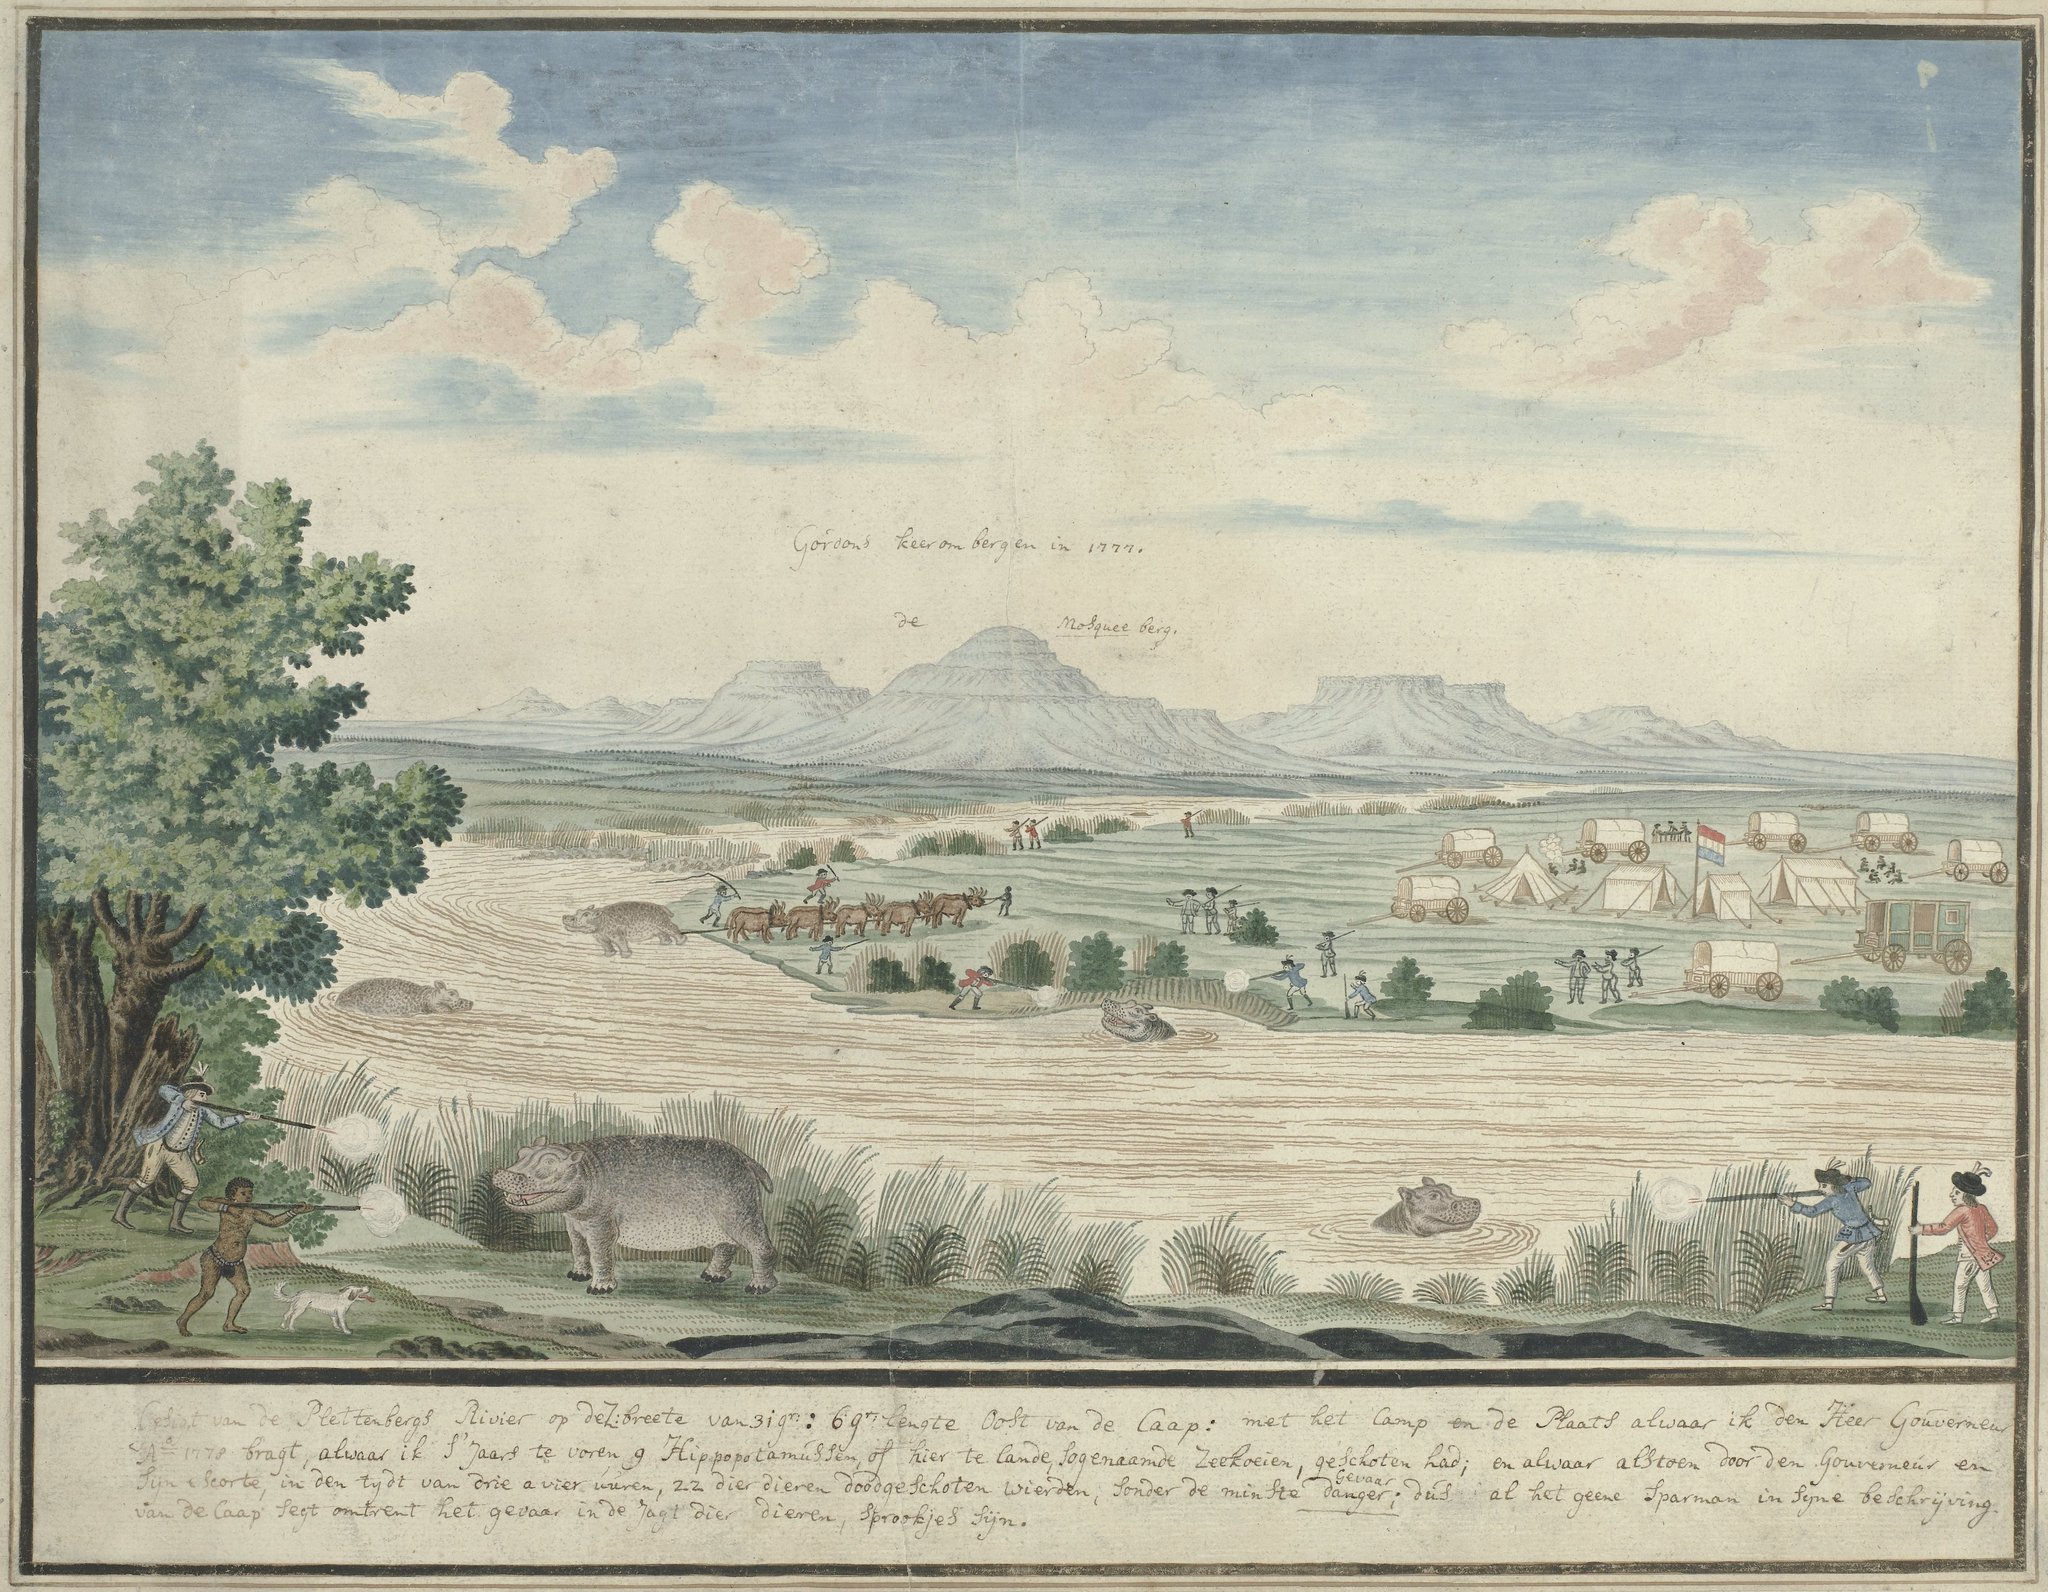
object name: topographical view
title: Hippopotamus hunt at the Seekoei River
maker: robert jacob gordon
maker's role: draughtsman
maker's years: 1743-1795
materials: ink, paper, pencil, watercolor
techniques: brush, pen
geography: cape province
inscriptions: annotation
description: Oorspronkelijk in omslag van roodkleurig halfleer en roodgemarmerd plat, dorso met ribben en goudopdruk; 71 x 99 x 6 cm.